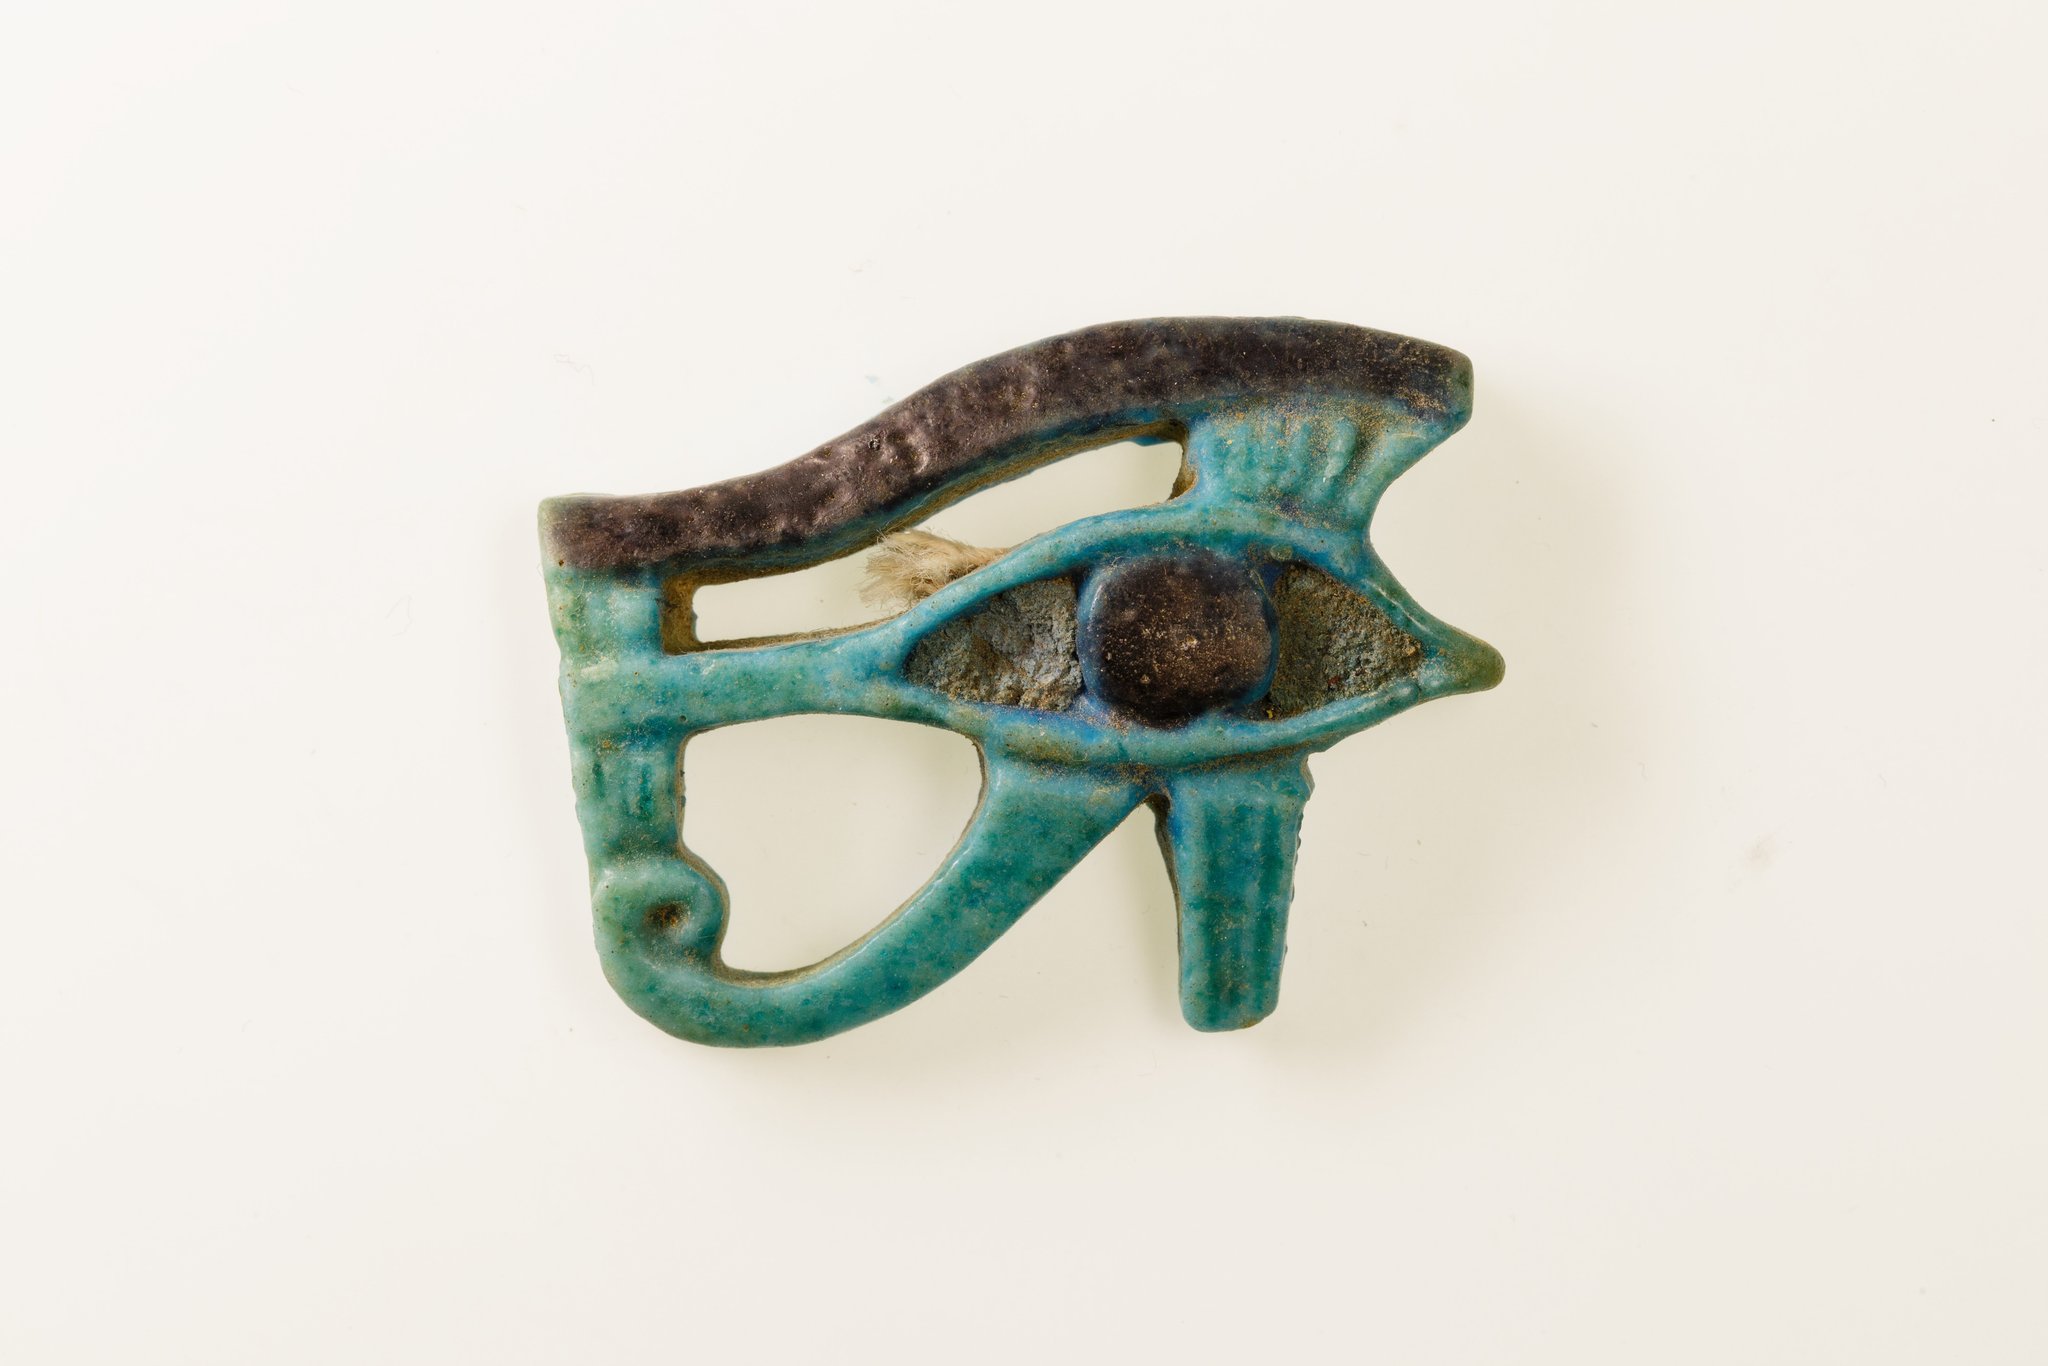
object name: amulet, wedjat eye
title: Wedjat Amulet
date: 712-332 BCE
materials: faience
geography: egypt